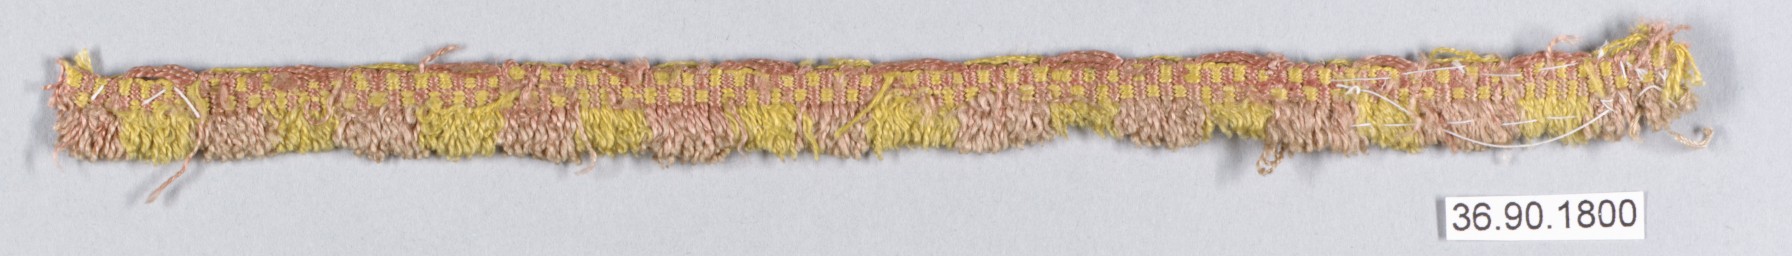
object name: fringe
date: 1701-1800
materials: silk